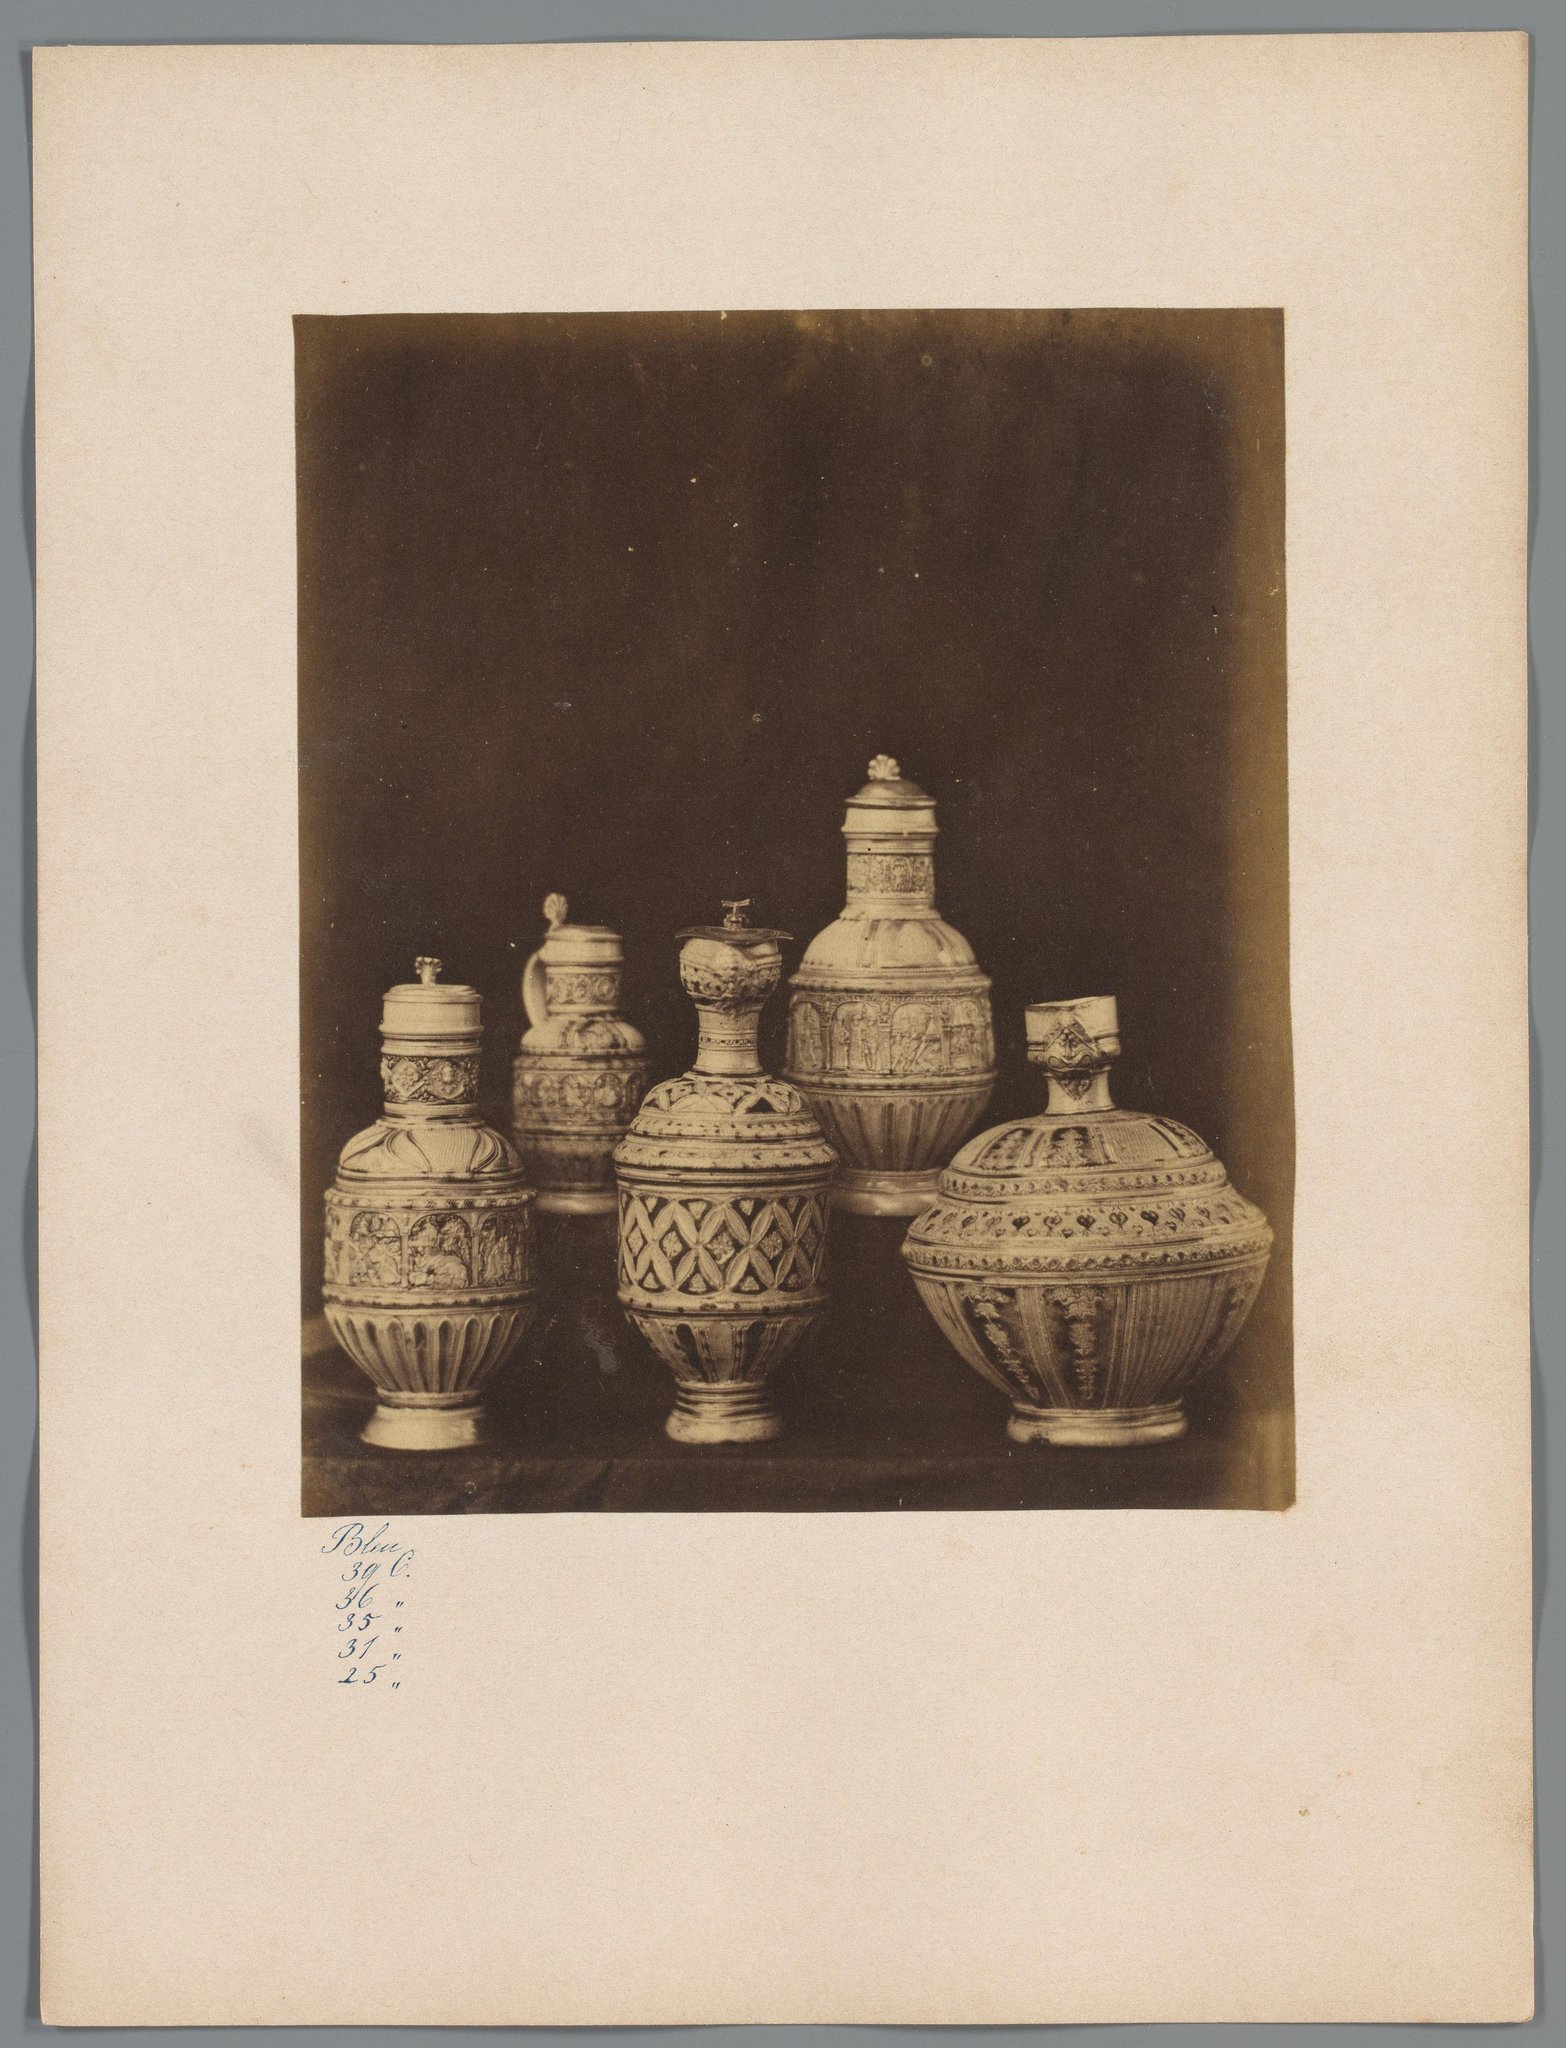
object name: photograph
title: Vijf aardewerken vazen uit de collectie van W. de Weckherlin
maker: Anonymous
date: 1860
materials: paper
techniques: albumen print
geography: the hague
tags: container of ceramics: jar, jug, pot, vase, the hague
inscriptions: inscription: ‘Bleu/ 39G./ 36"/ 35"/ 31"/ 24"’